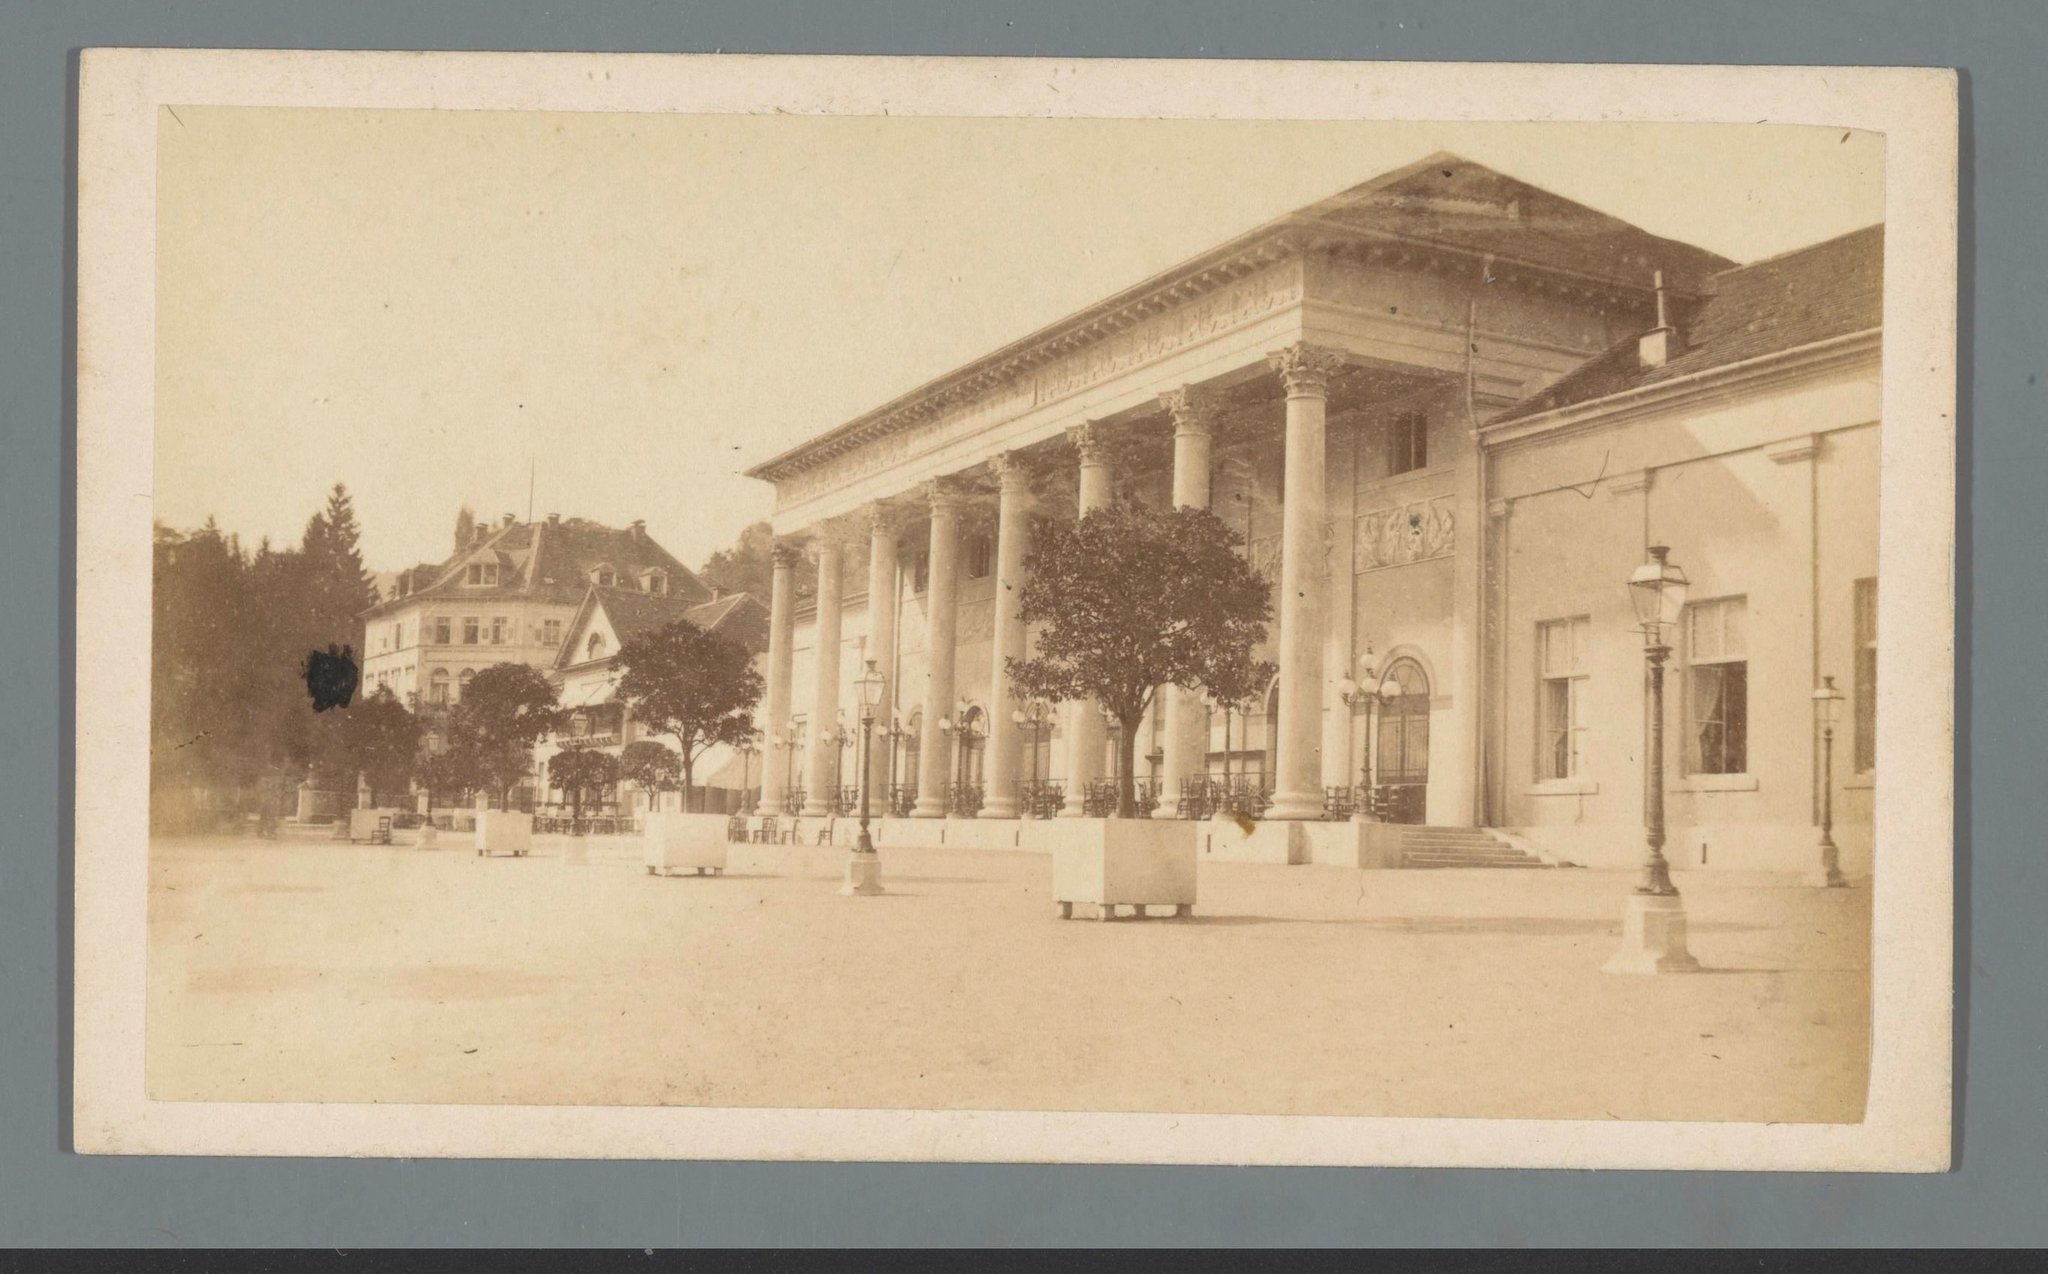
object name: photograph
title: Plein in onbekende stad, Frankrijk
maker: Anonymous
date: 1865-1880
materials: cardboard, paper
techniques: albumen print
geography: france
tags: city-view in general; 'veduta', france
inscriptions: annotation: ‘COLLECTION DES TOURISTES / Vues des Villes d’Eaux d’Allemagne / LES BORDS DU RHIN – LA FORÊT NOIRE / & L’ALSACE’